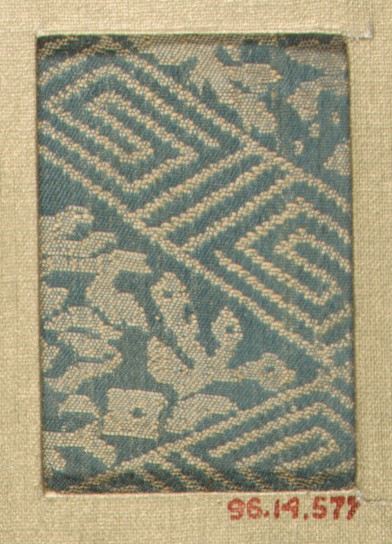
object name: piece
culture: japanese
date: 1701-1900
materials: silk